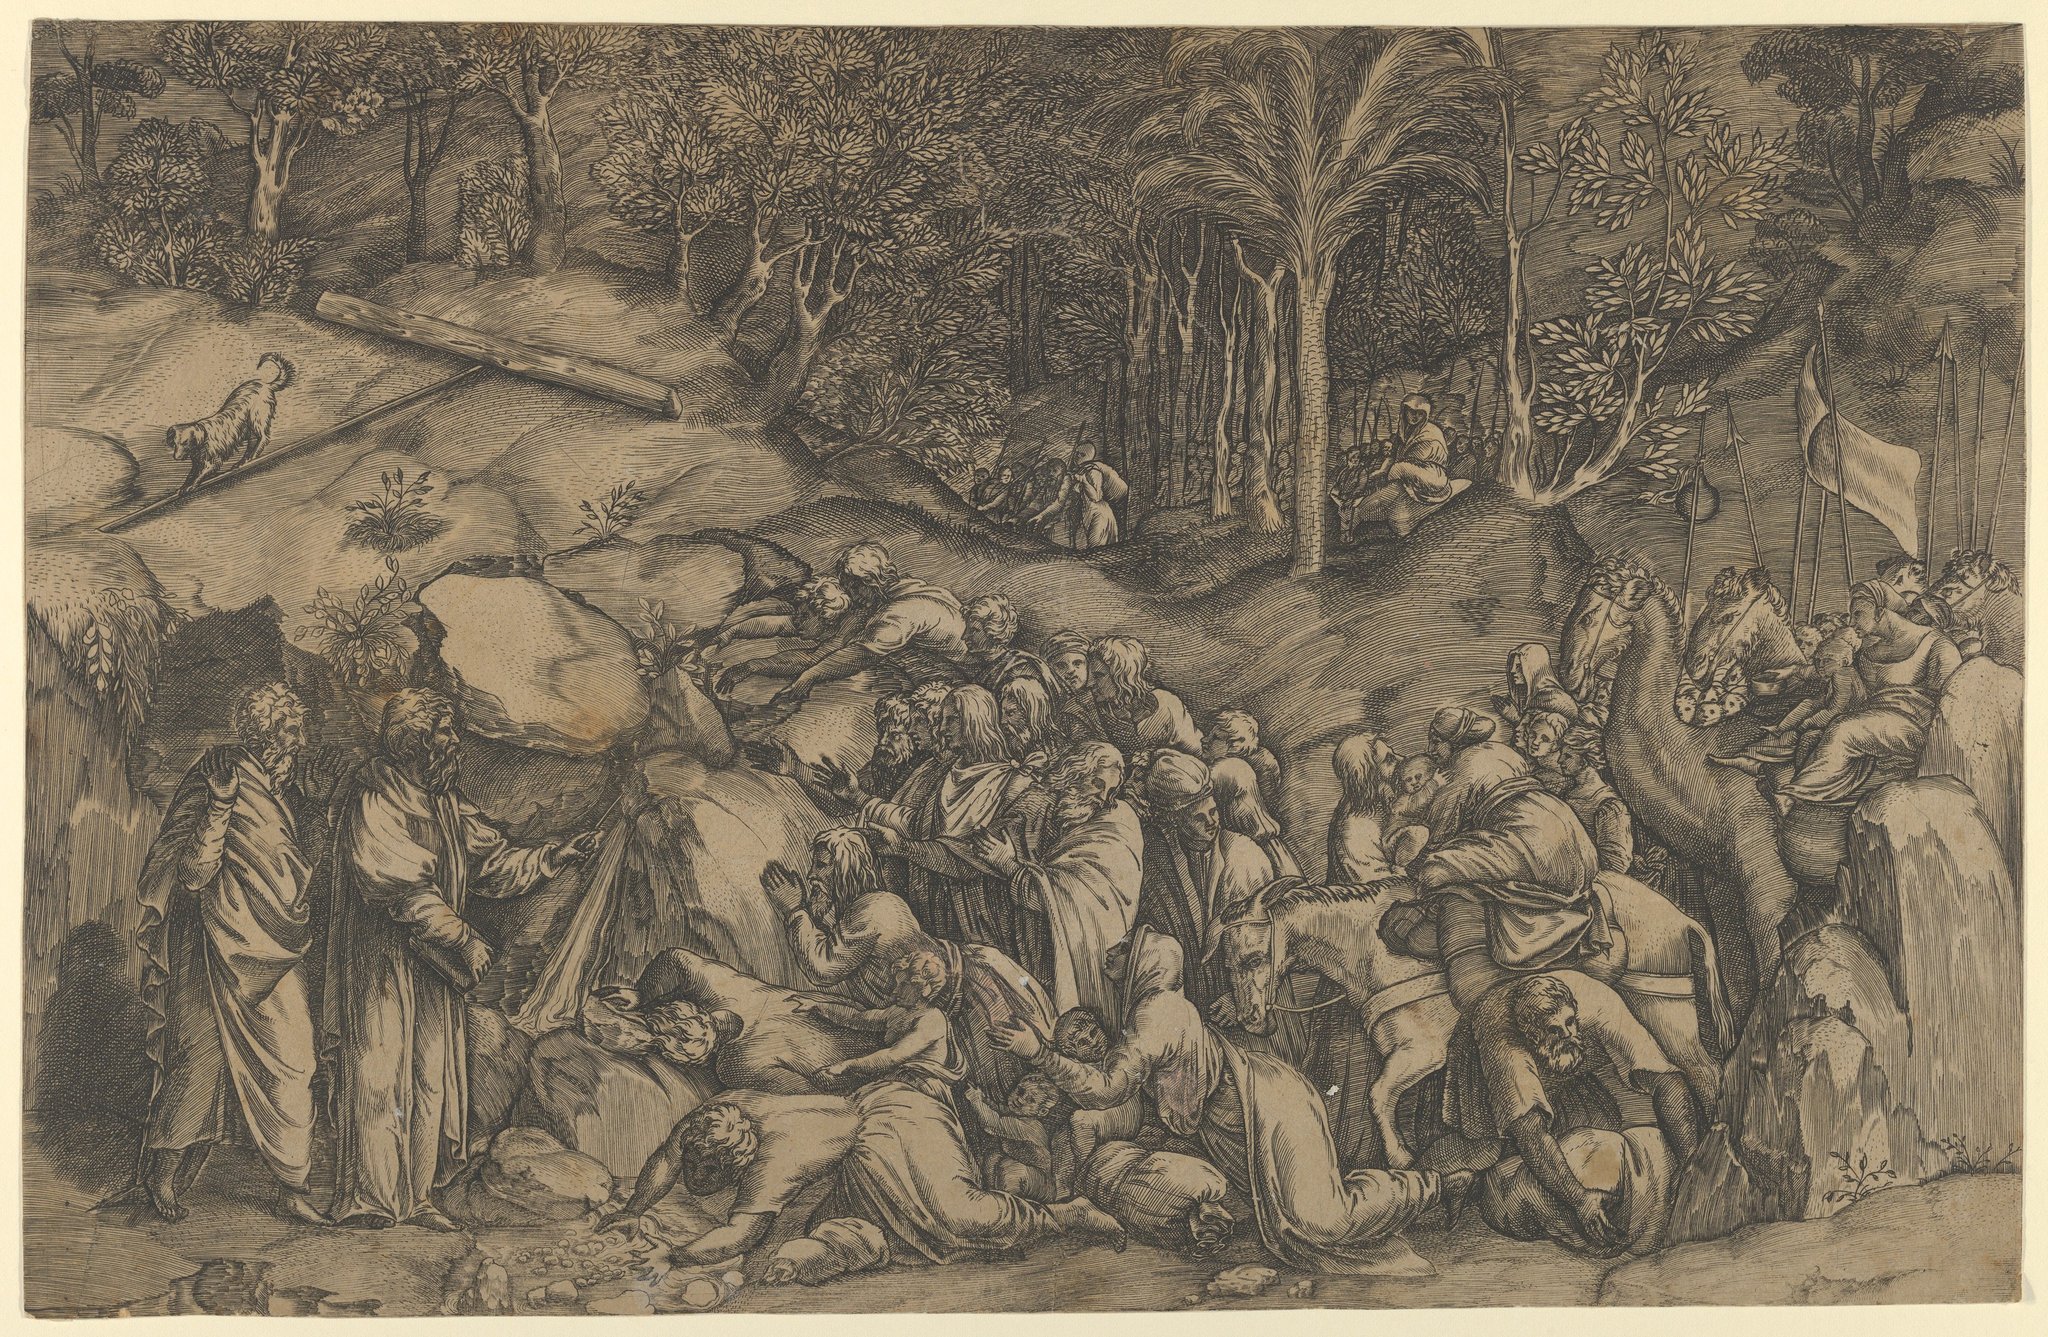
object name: print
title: Moses striking the Rock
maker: anonymous, italian?, 16th century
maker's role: artist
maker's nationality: italian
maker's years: 1500-1600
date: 1530-1550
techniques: engraving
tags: horses,trees,moses